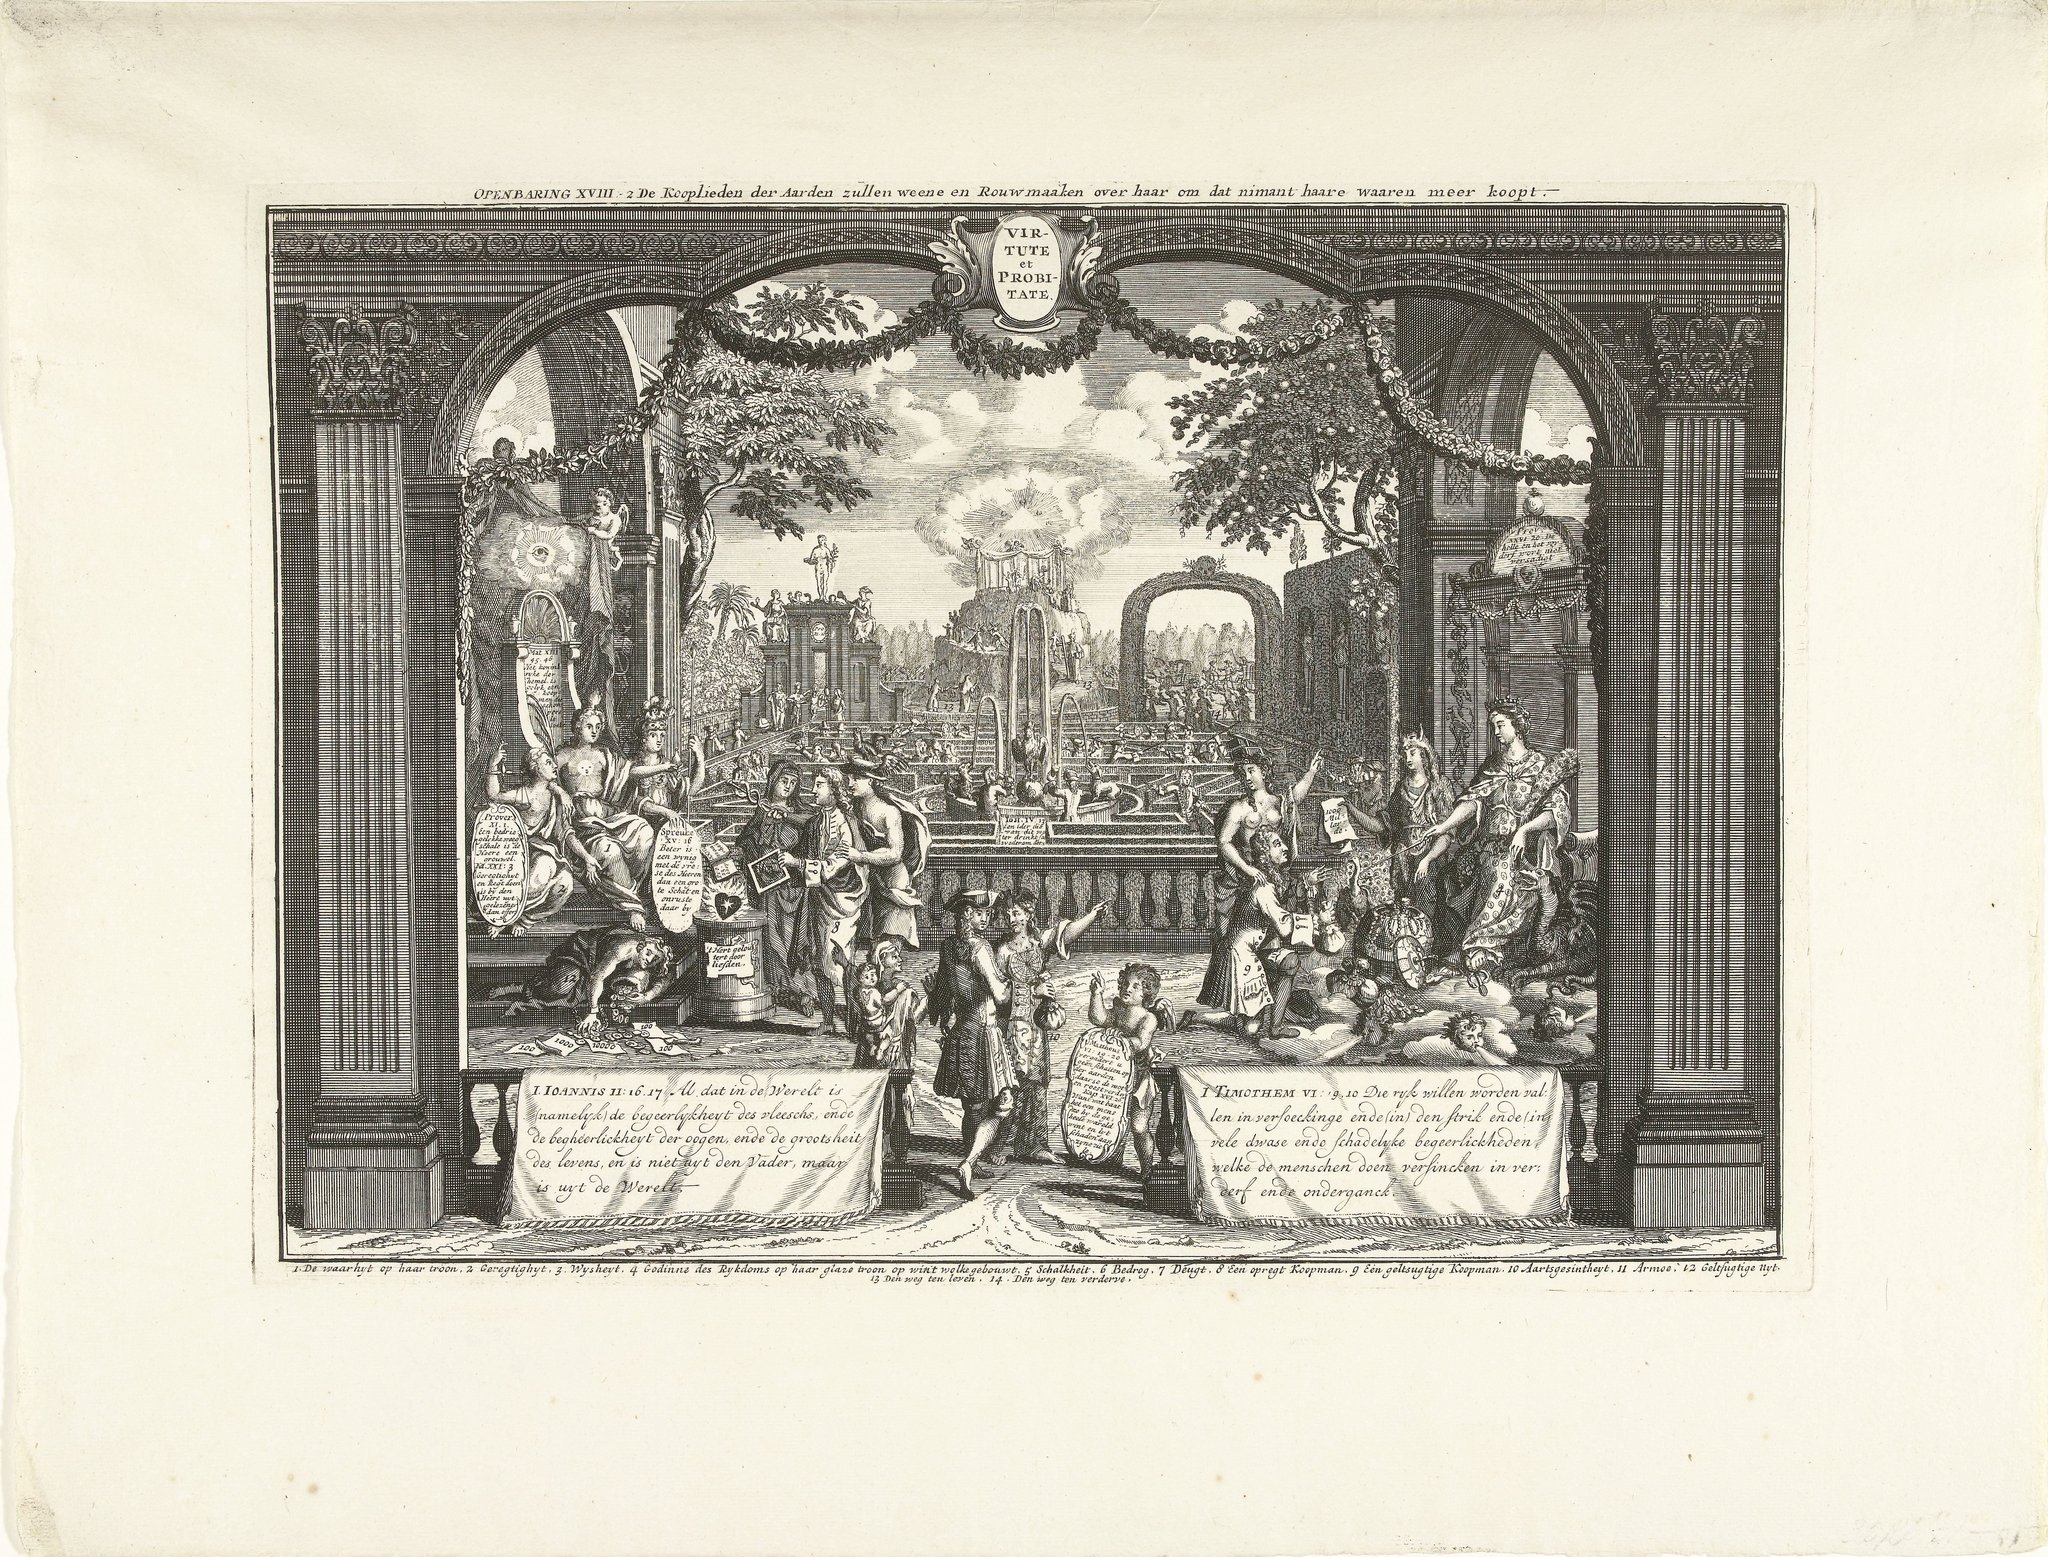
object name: print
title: Virtute et Probitate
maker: Anonymous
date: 1720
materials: paper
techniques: engraving, etching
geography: northern netherlands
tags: labyrinth, maze ~ garden, the way to destruction is broad and the gate is wide; the way to life is narrow and the gate is straight ~ doctrine of christ on love, etc. (matthew 7:13-14; luke 13:24), merchant, salesman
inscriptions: collector's mark: Lugt 2228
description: De oprechte en de geldzuchtige koopman. Links de oprechte koopman met Mercurius en Deugd voor de troon van de Waarheid, rechts de geldzuchtige koopman (de windhandelaar) met Bedrog en Schalkheid voor de troon van de Rijkdom. Op de balustrade bijbelcitaten. Op de achtergrond een tuin met een doolhof met de smalle en de brede weg. In het onderschrift de legenda 1-14. Prent 51 in de serie Het Groote Tafereel der Dwaasheid met spotprenten op de Windhandel of Actiehandel van 1720.